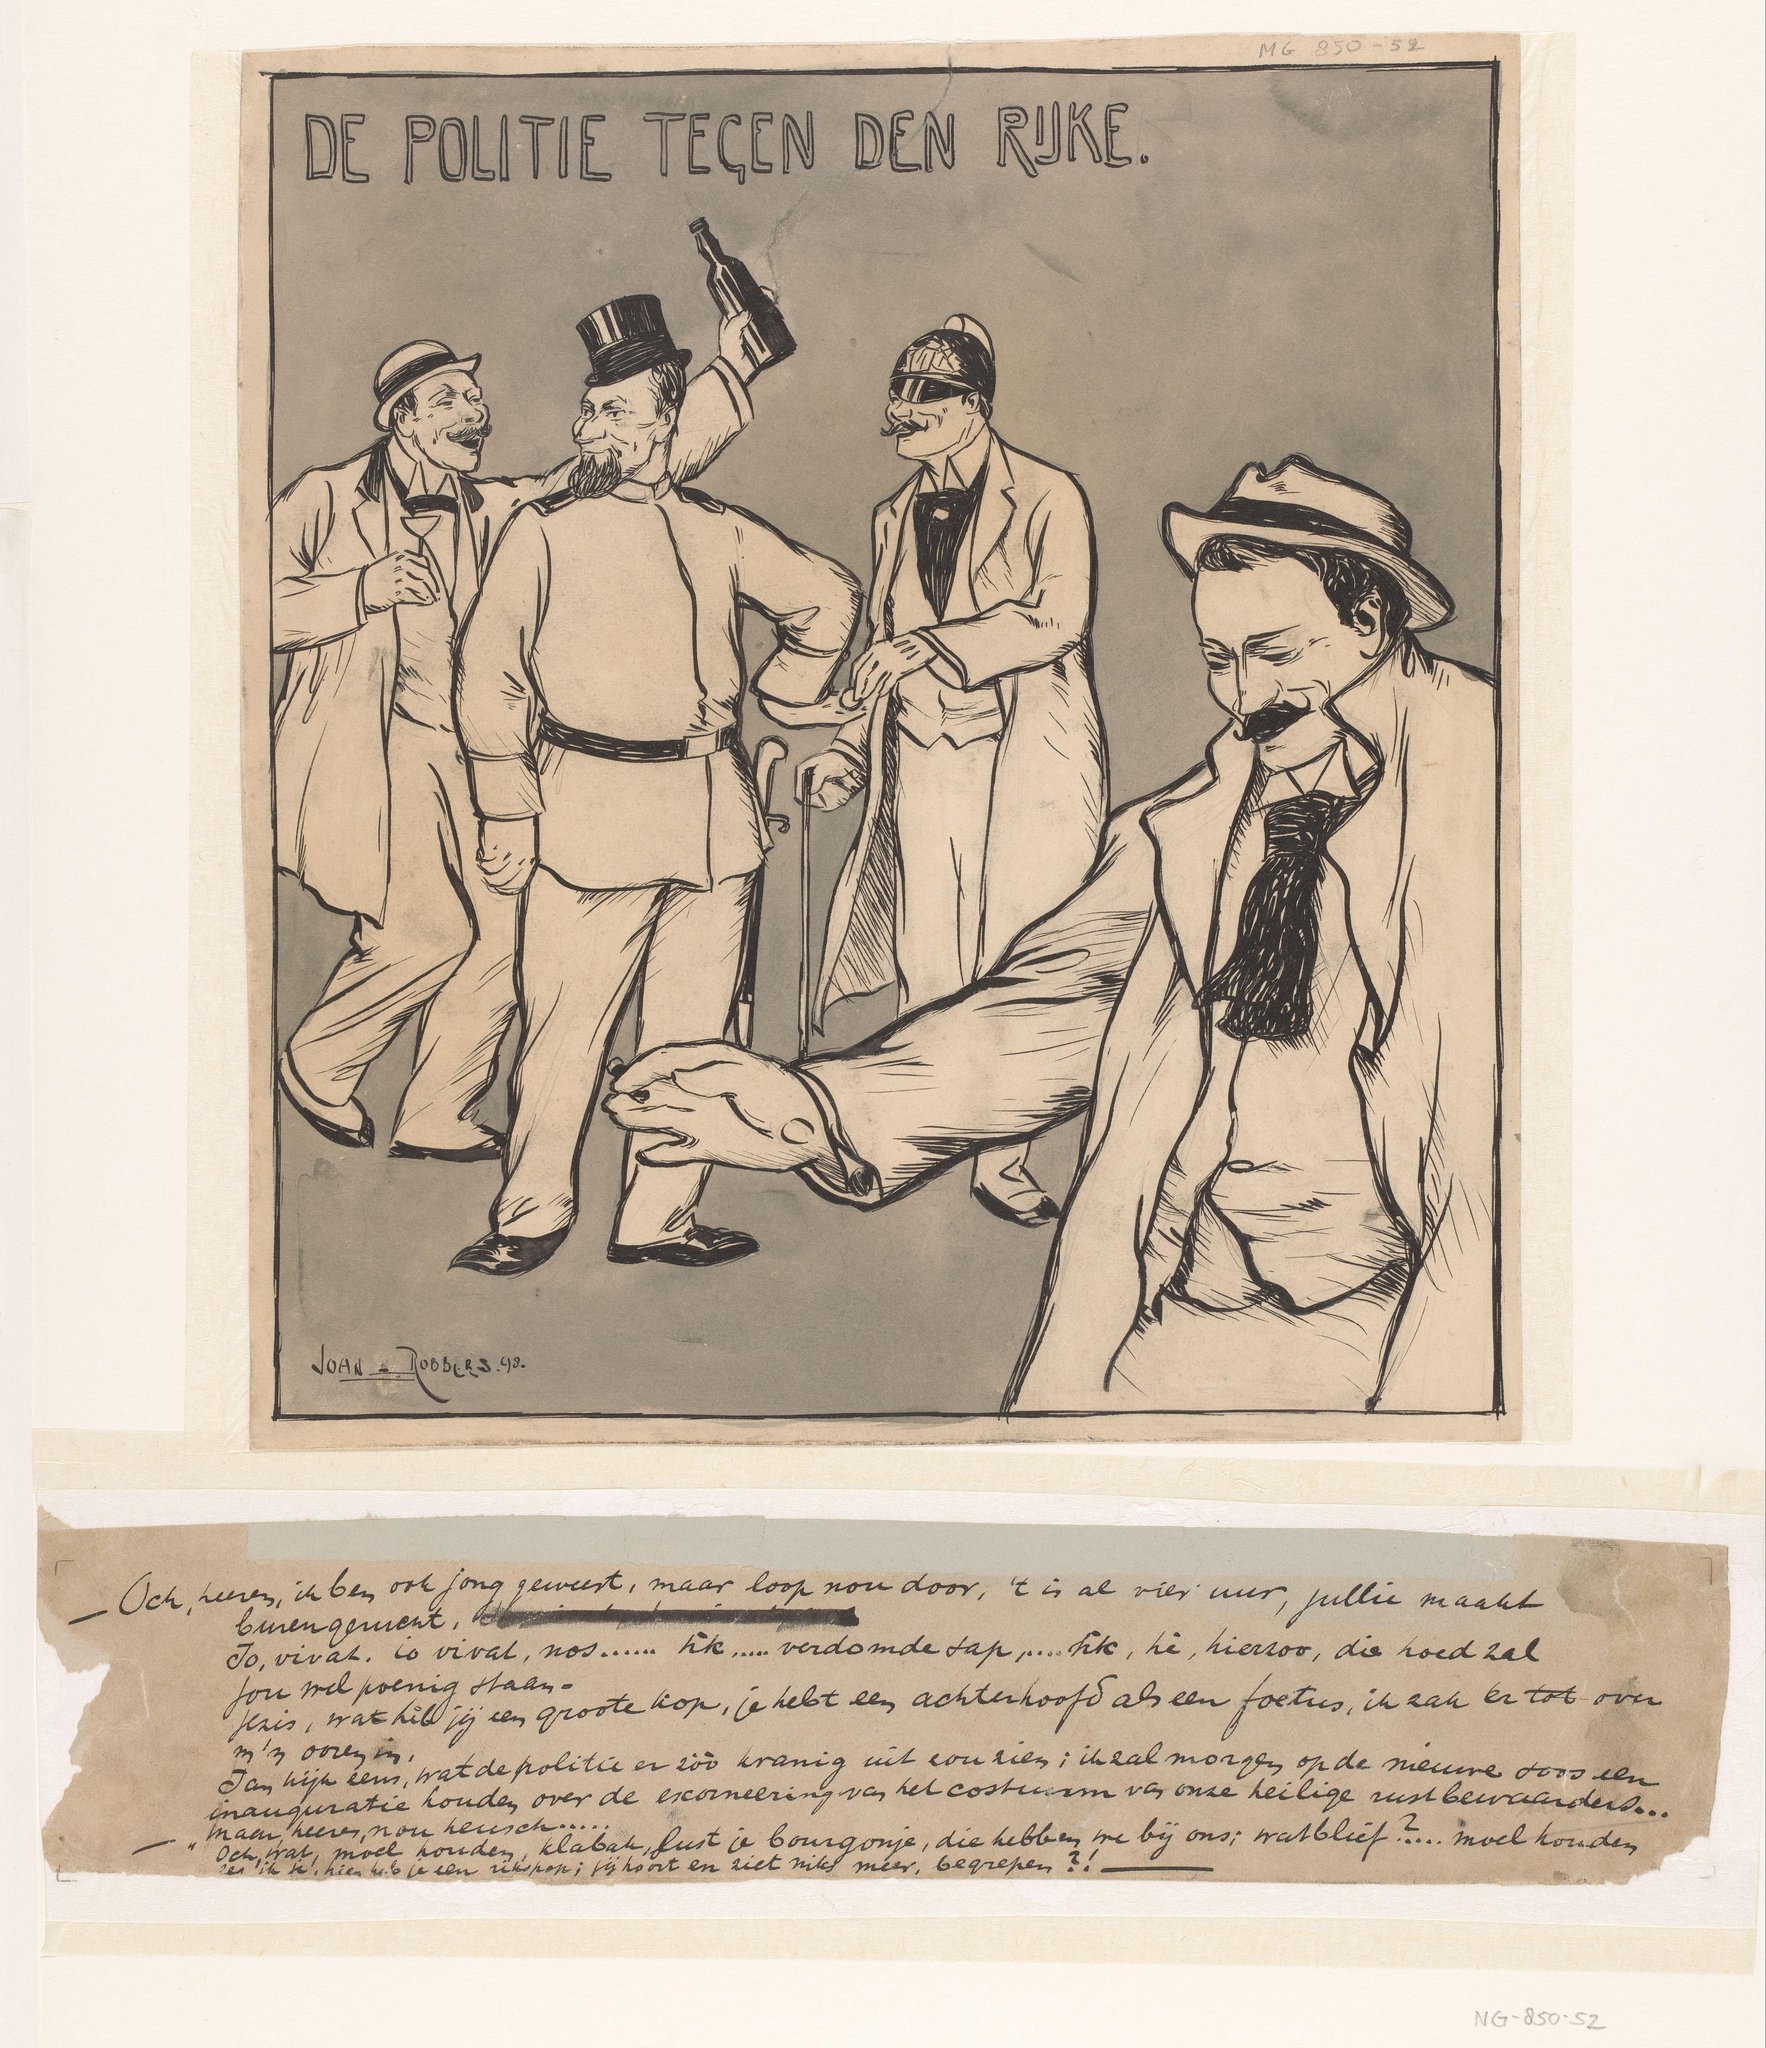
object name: drawing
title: De politie tegen den rijke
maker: joan robbers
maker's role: draughtsman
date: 1898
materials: ink, paper, pencil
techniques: brush, pen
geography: netherlands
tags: the rich, policeman, constable, drunkenness, netherlands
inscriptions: date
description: Links een dronken man met glas in rechterhand en fles in opgeheven linkerhand, naast hem de agent met een hoge hoed, die met de linkerhand achter zijn rug een geldstuk aanneemt van de derde man, burger met wandelstok en politiehelm op. Rechts op de voorgrond een vierde man, zijn rechterhand met sigarenpeuk naar links wijzend. De politie knijpt een oogje dicht als rijke mensen op straat overlast veroorzaken. Op een apart strookje papier de woorden van de agent en de dronkaards. Pendant van de tekening: De politie tegen de arme.